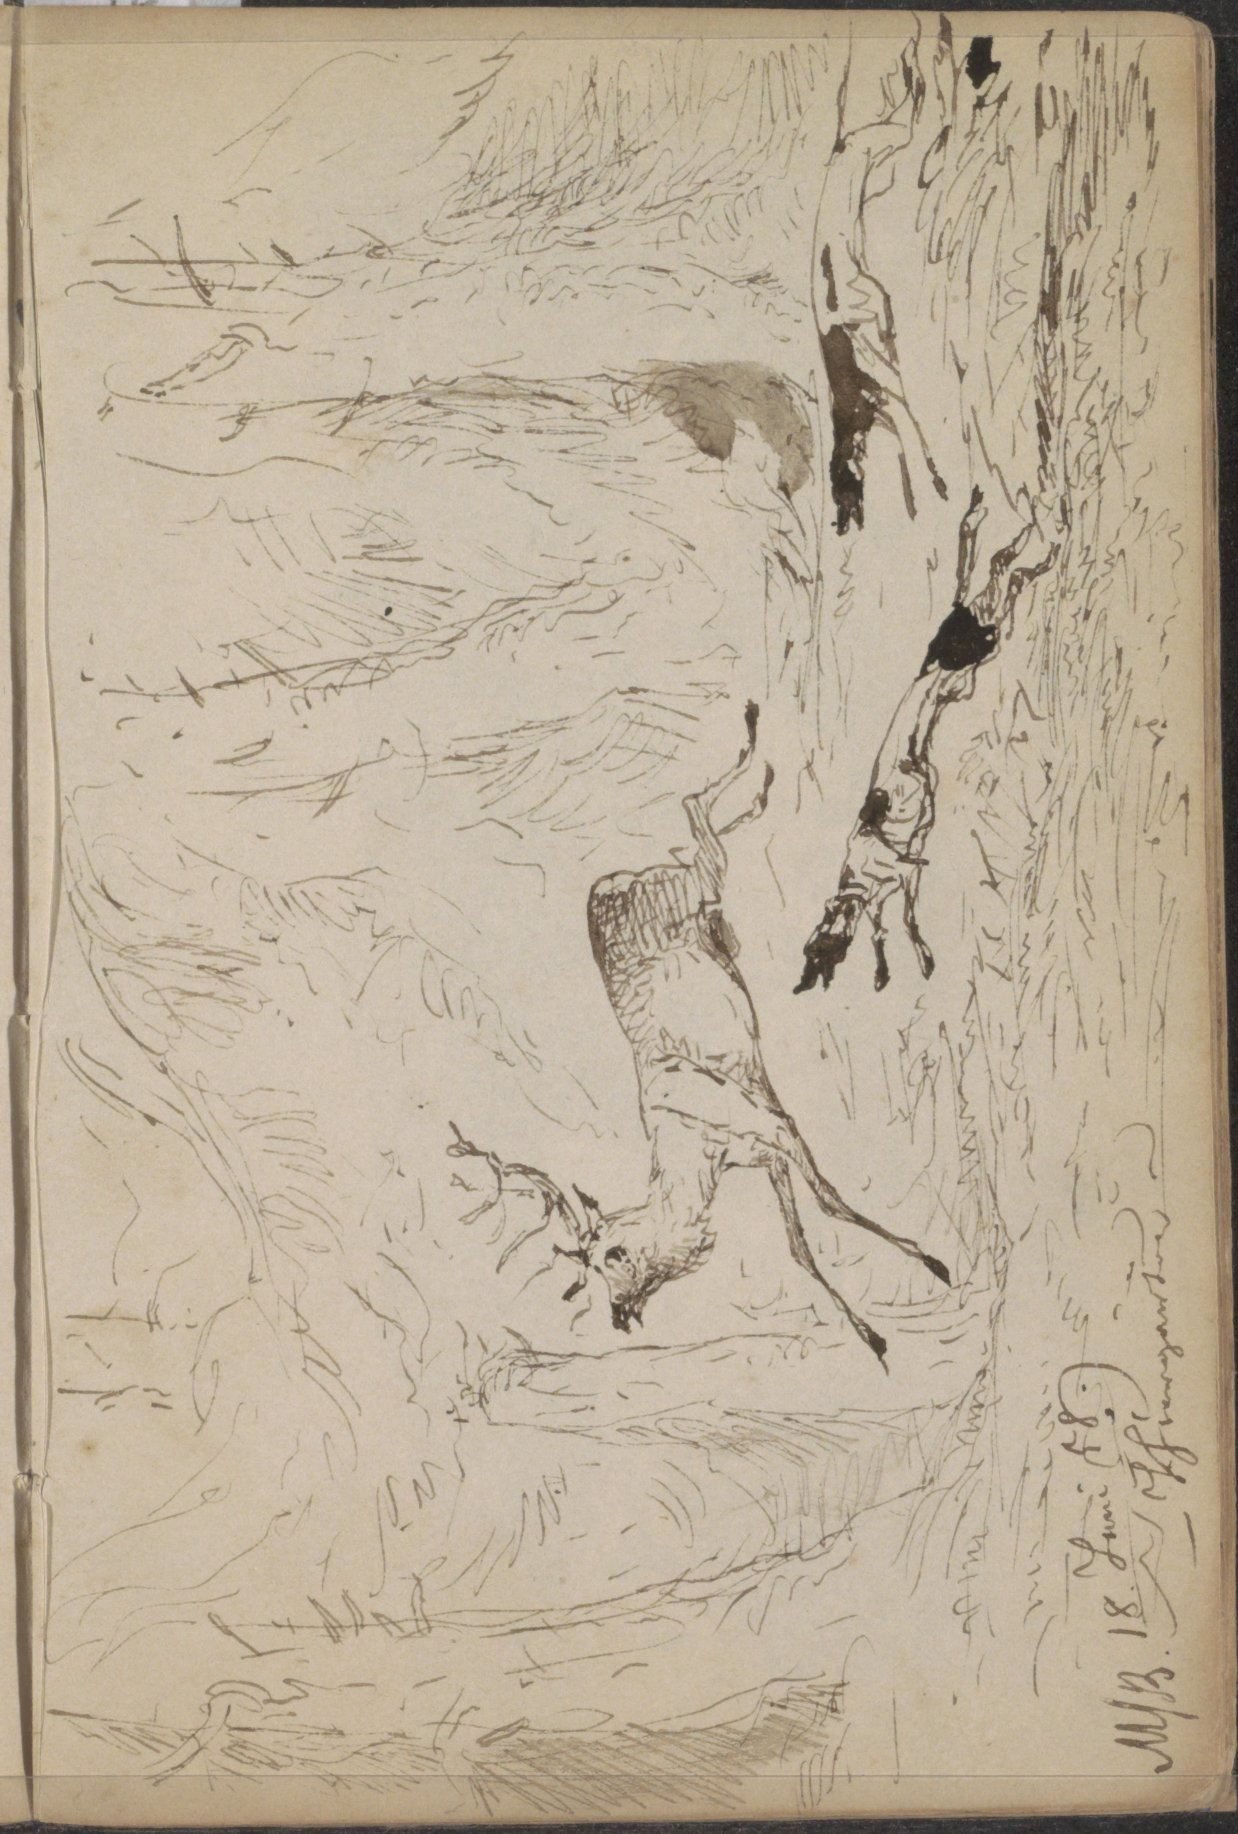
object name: sketchbook leaf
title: Diergaarde met twee honden die op een hert jagen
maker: johannes tavenraat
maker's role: draughtsman, painter, print maker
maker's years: 1809-1881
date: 1806-1858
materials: ink, paper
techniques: pen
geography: bohemia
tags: hoofed animals: deer, forest, wood, zoological garden, zoo, seen as place where non-domestic animals are kept, dog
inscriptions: date and inscription: ‘M[...]B 18 Juni 58./ [...]iergarten’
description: Blad 21 recto uit een schetsboek met 44 bladen.